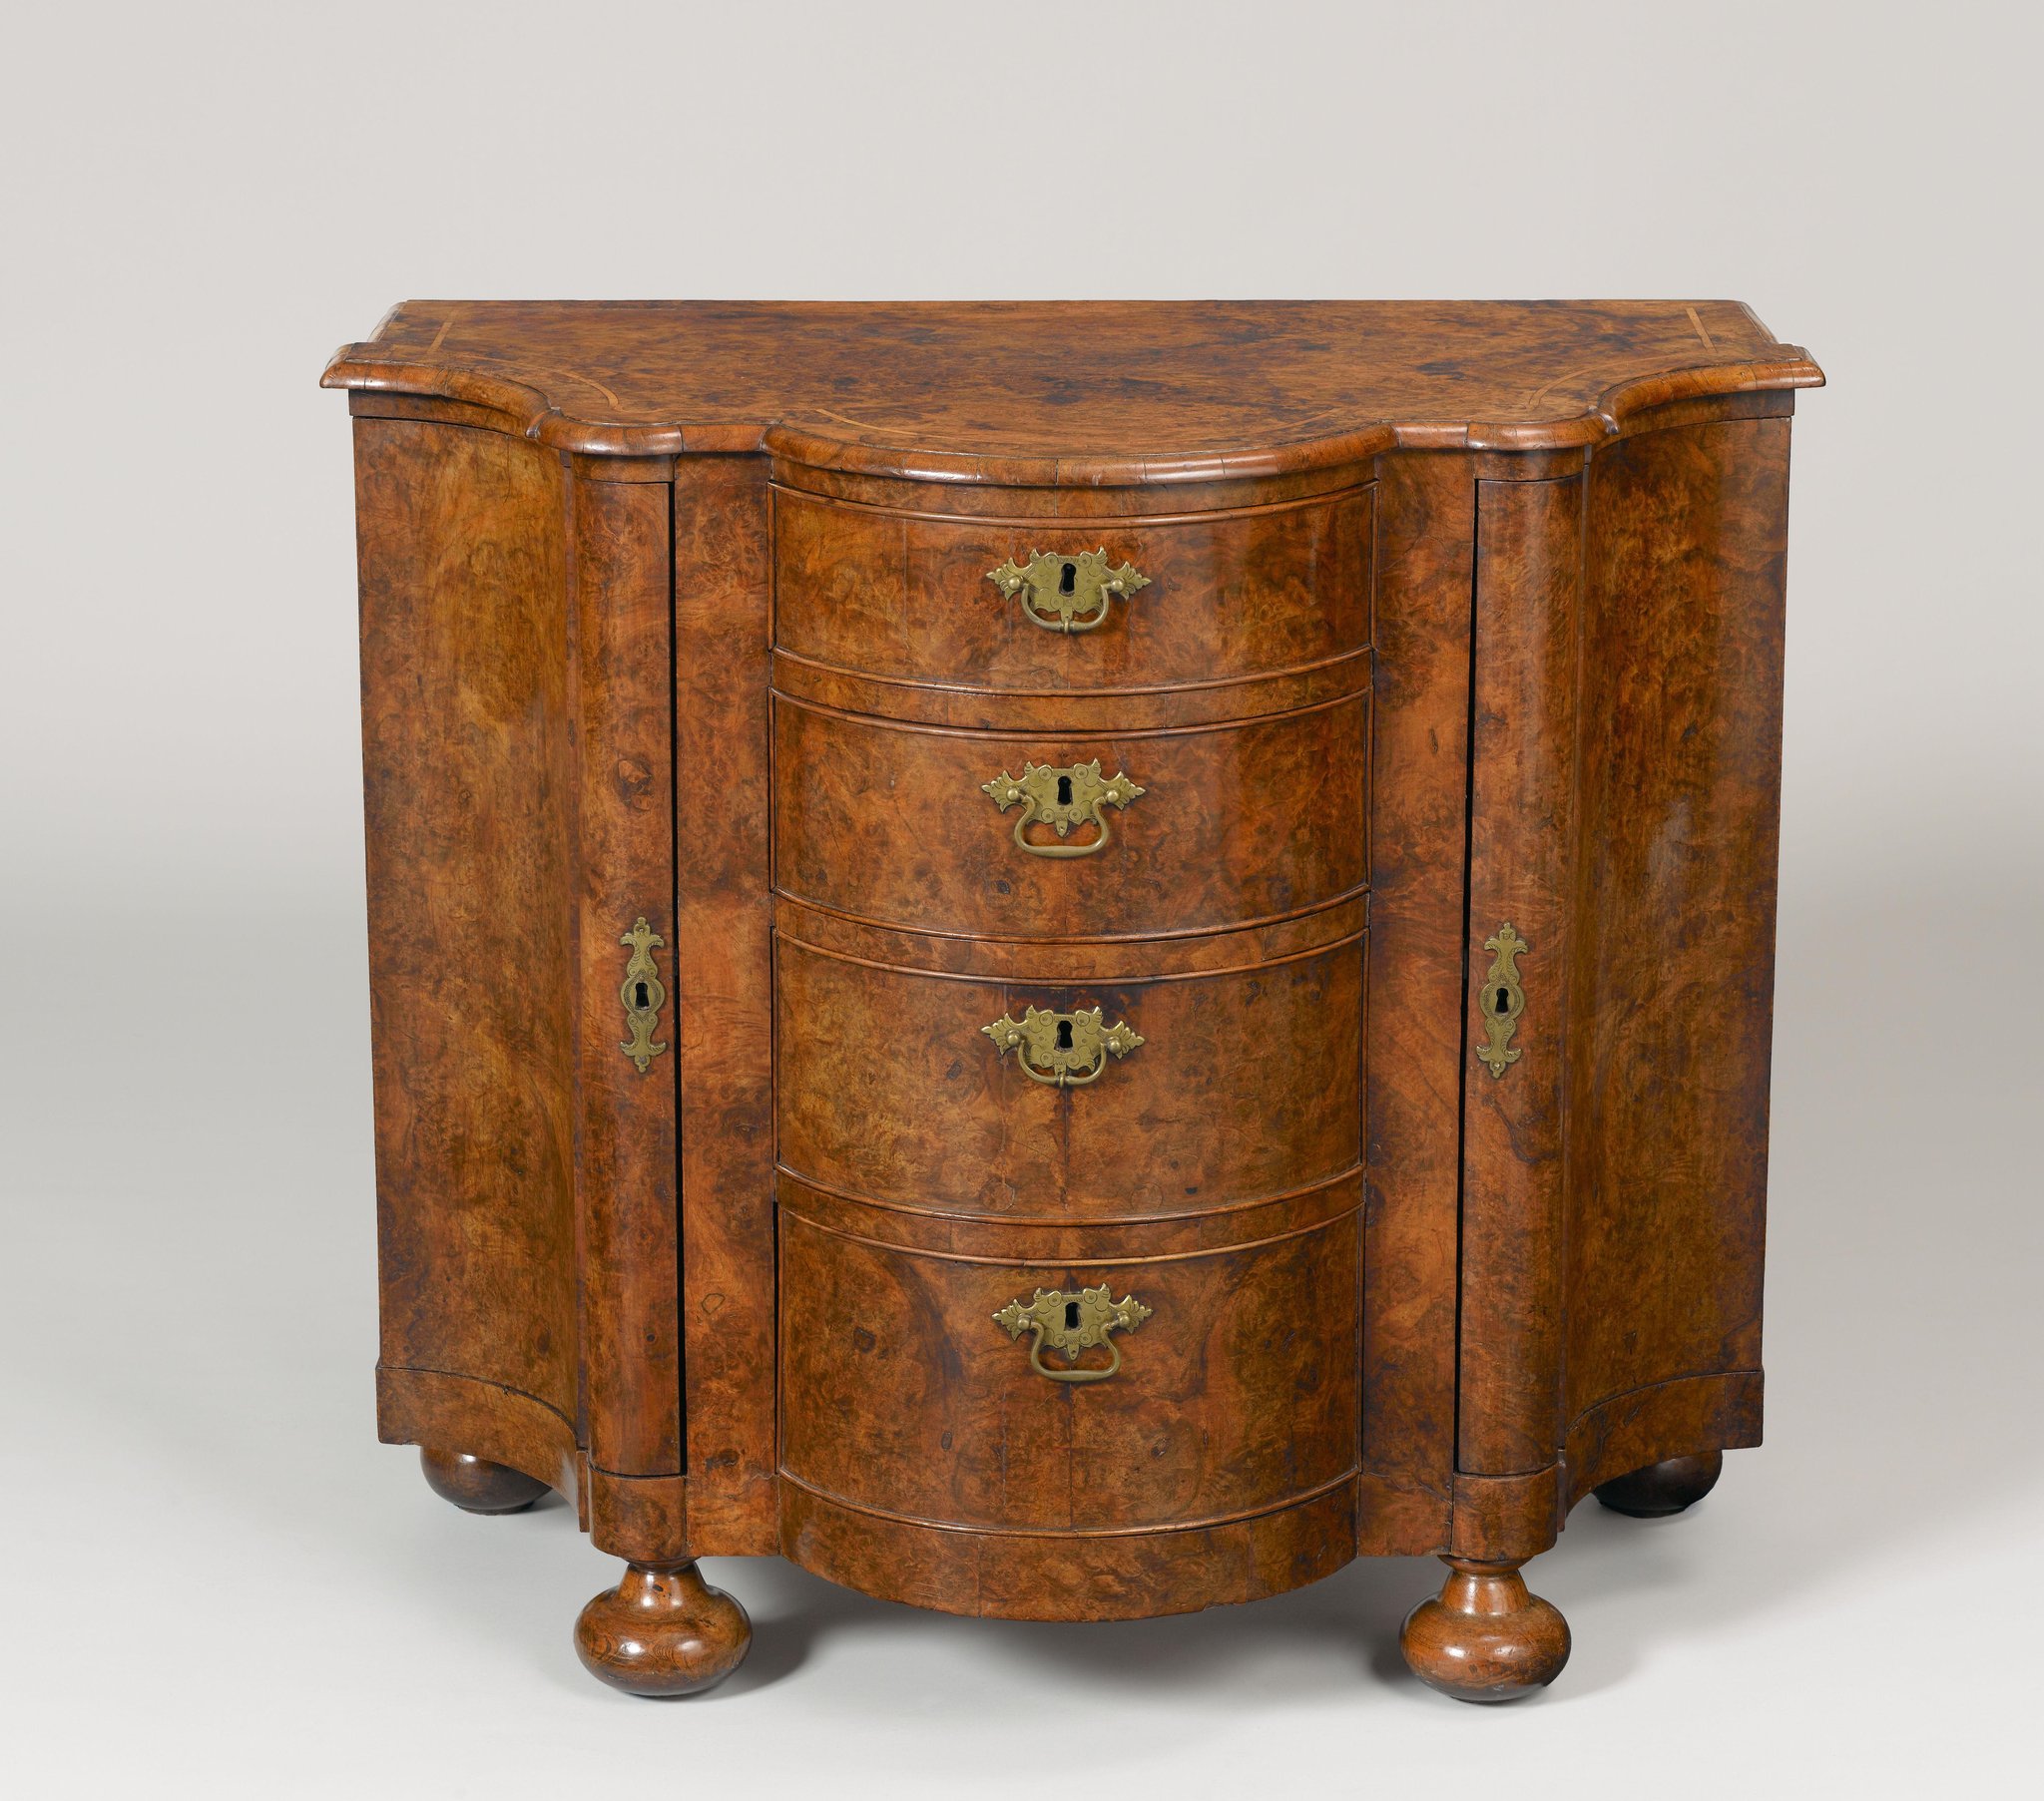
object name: furniture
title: Commode op vier bolpoten, met vier laden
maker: Anonymous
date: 1700-1725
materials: brass, wood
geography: northern netherlands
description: Commode. Oak, veneered with burr walnut. Netherlands, c. 1710 - 1740. Looking glass with frame, limewood, gilded. Netherlands (?), c. 1700 - 1725.